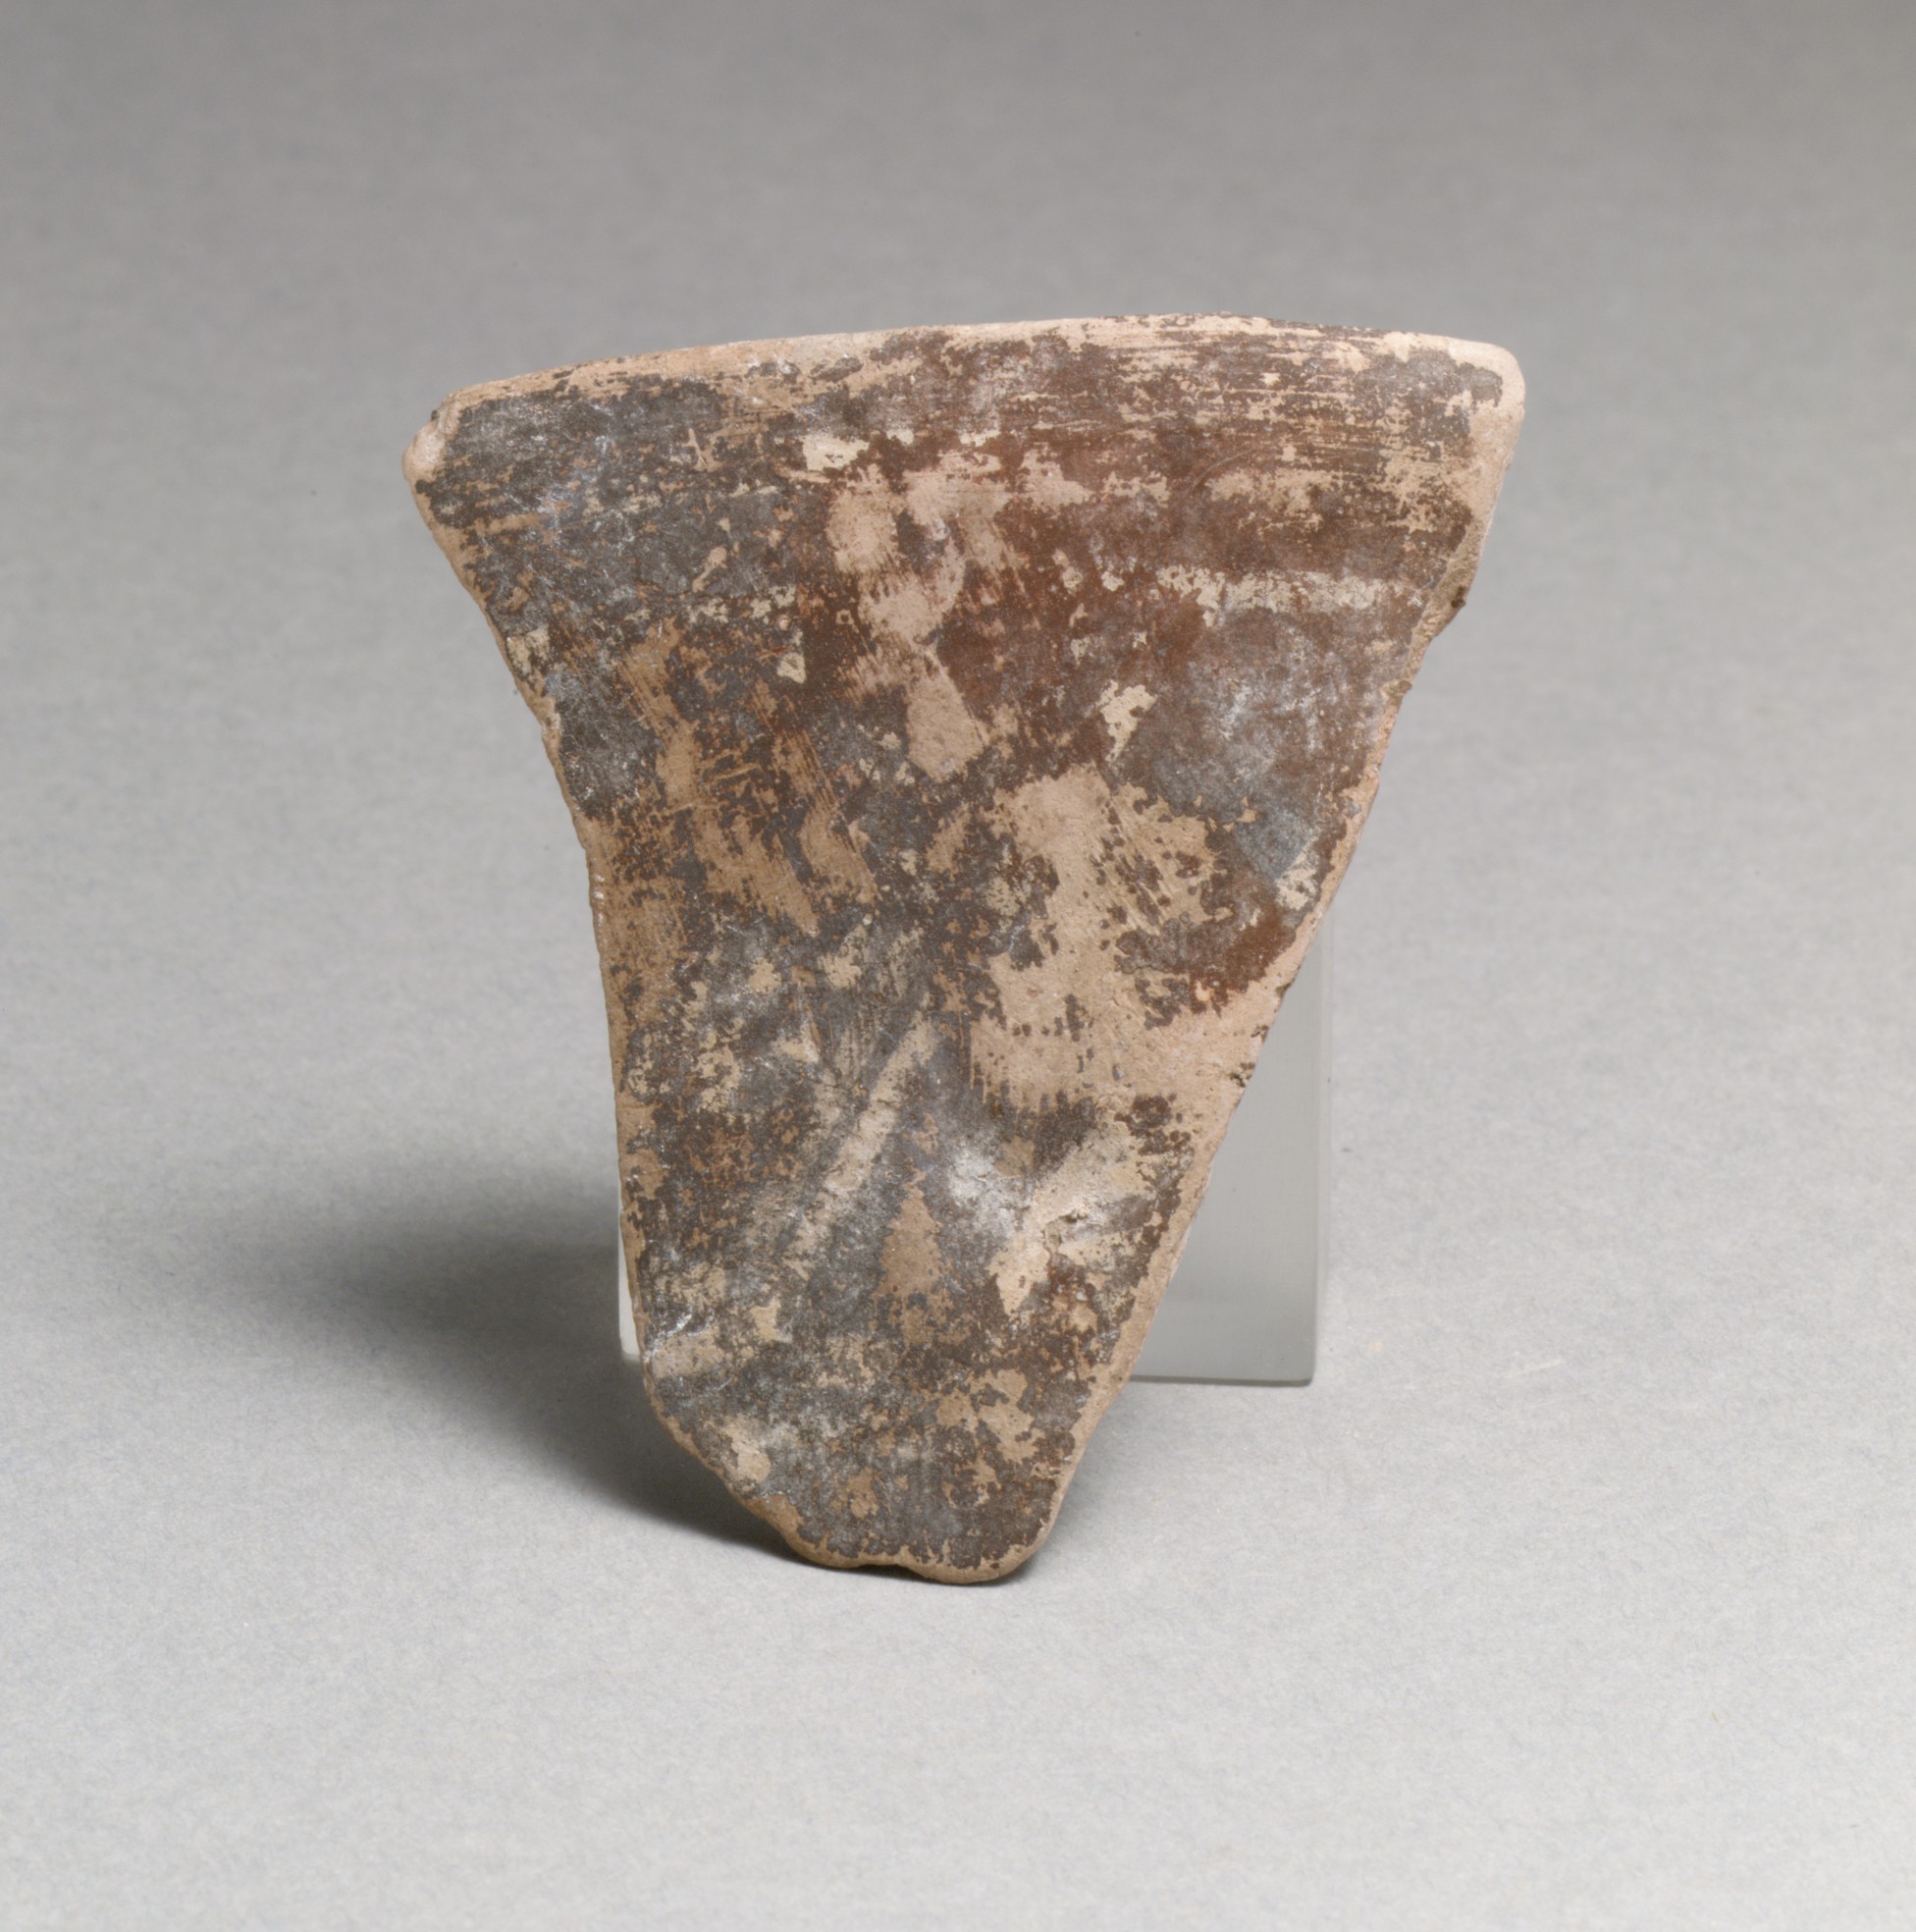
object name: vase fragment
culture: minoan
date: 2600-2000 BCE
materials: terracotta